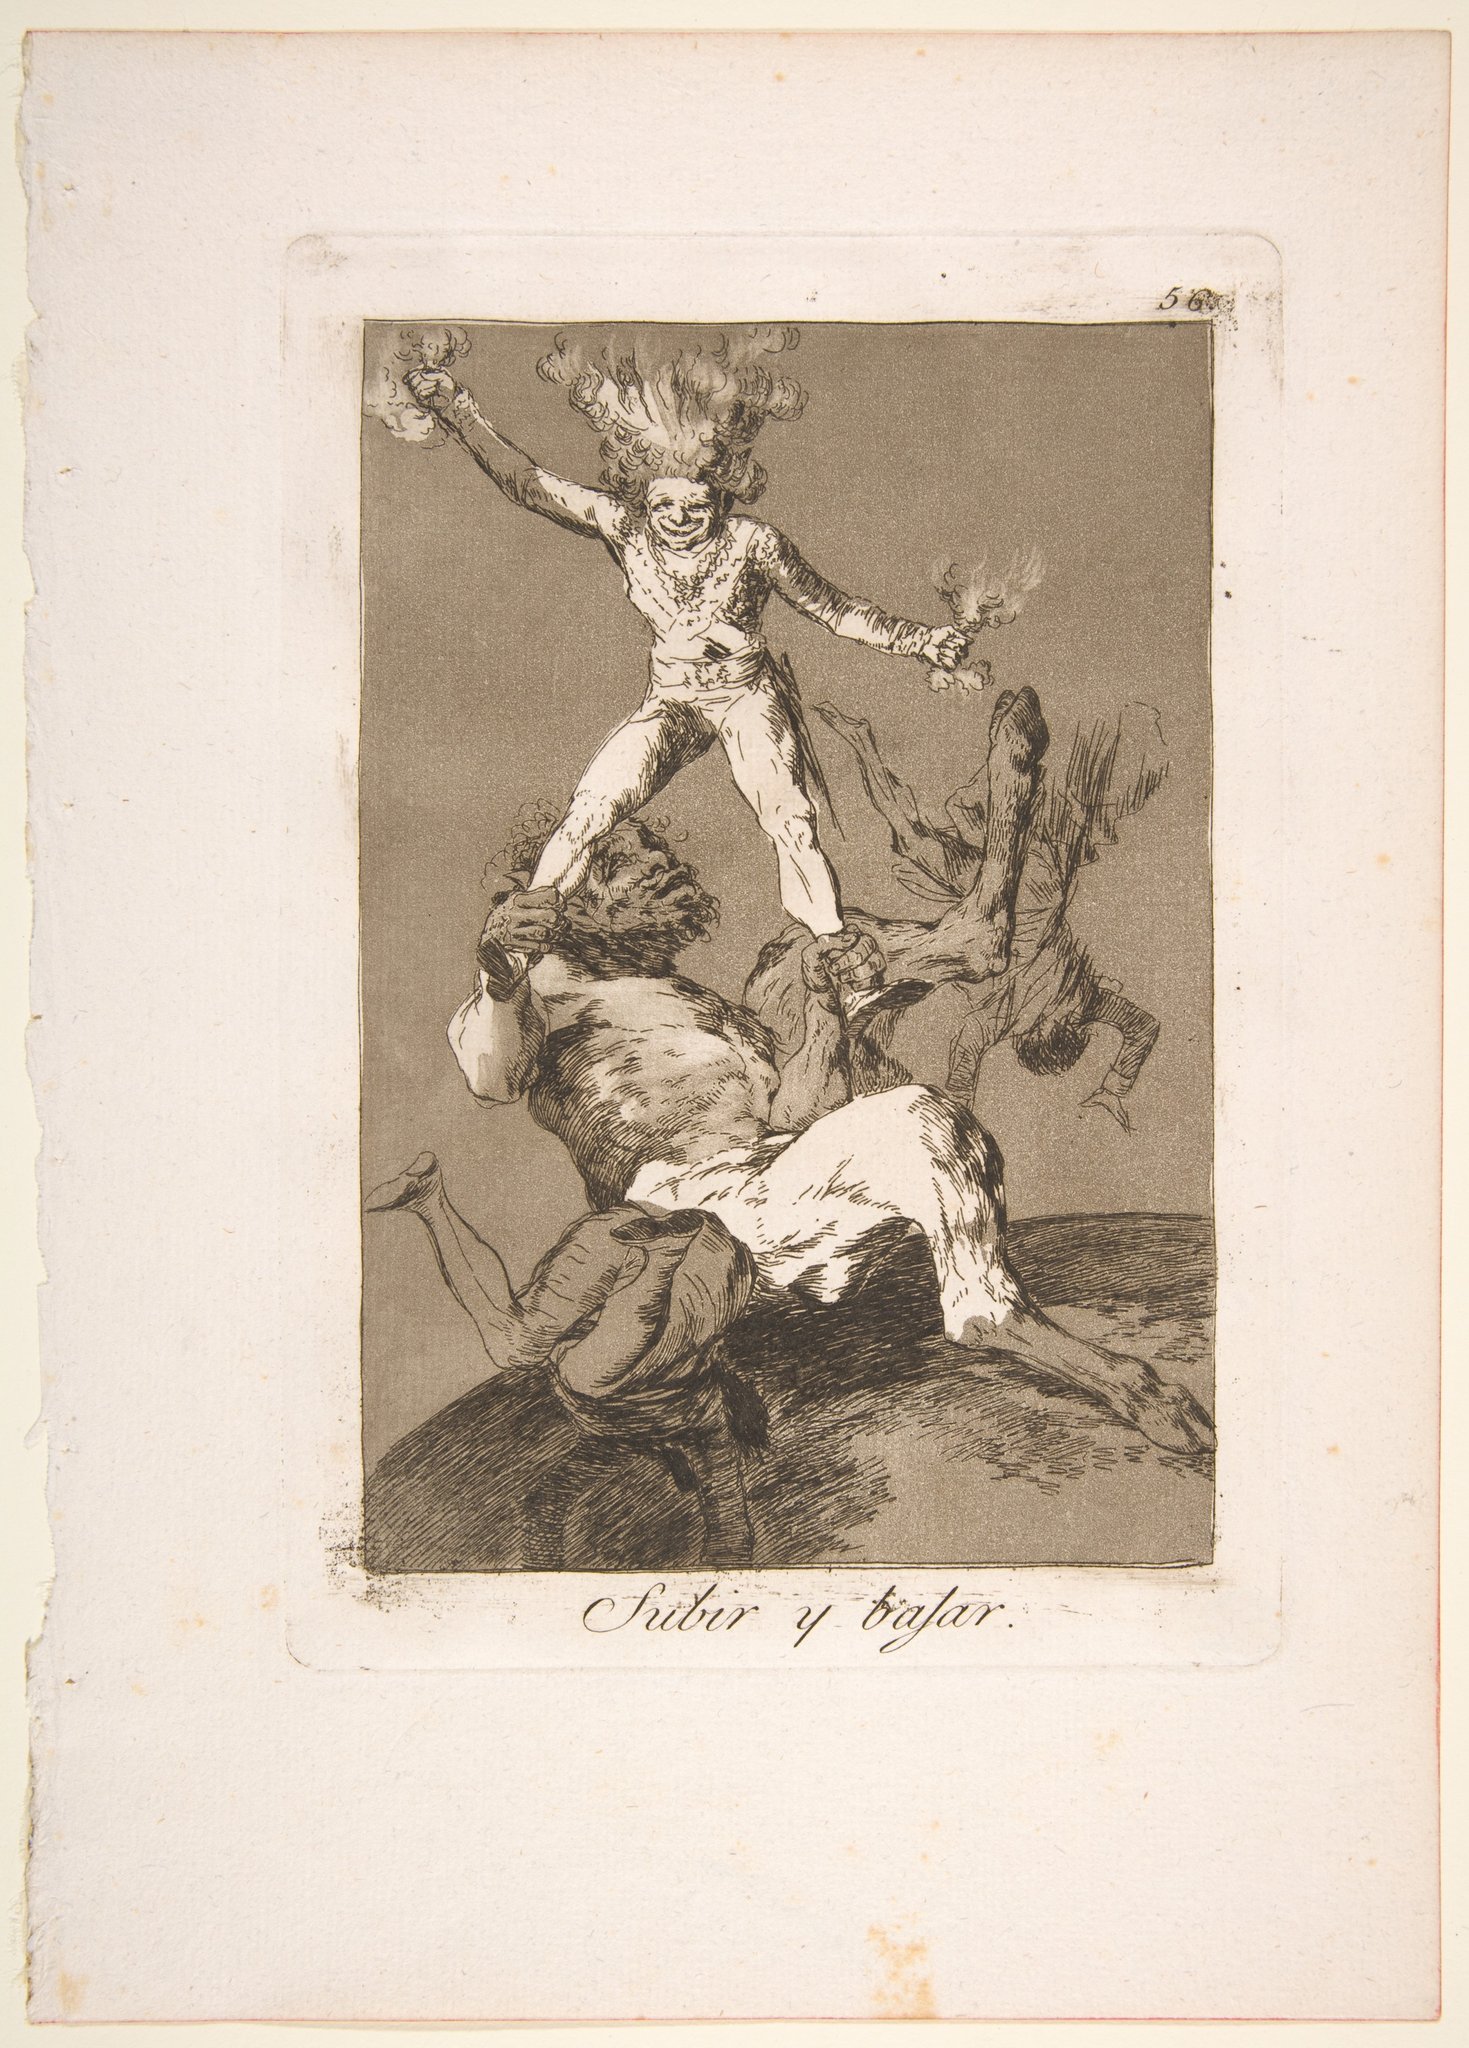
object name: print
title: Plate 56 from "Los Caprichos": To rise and to fall (Subir y bajar)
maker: goya (francisco de goya y lucientes)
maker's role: artist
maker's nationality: spanish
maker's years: 1746-1828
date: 1799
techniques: aquatint, burnishing, etching